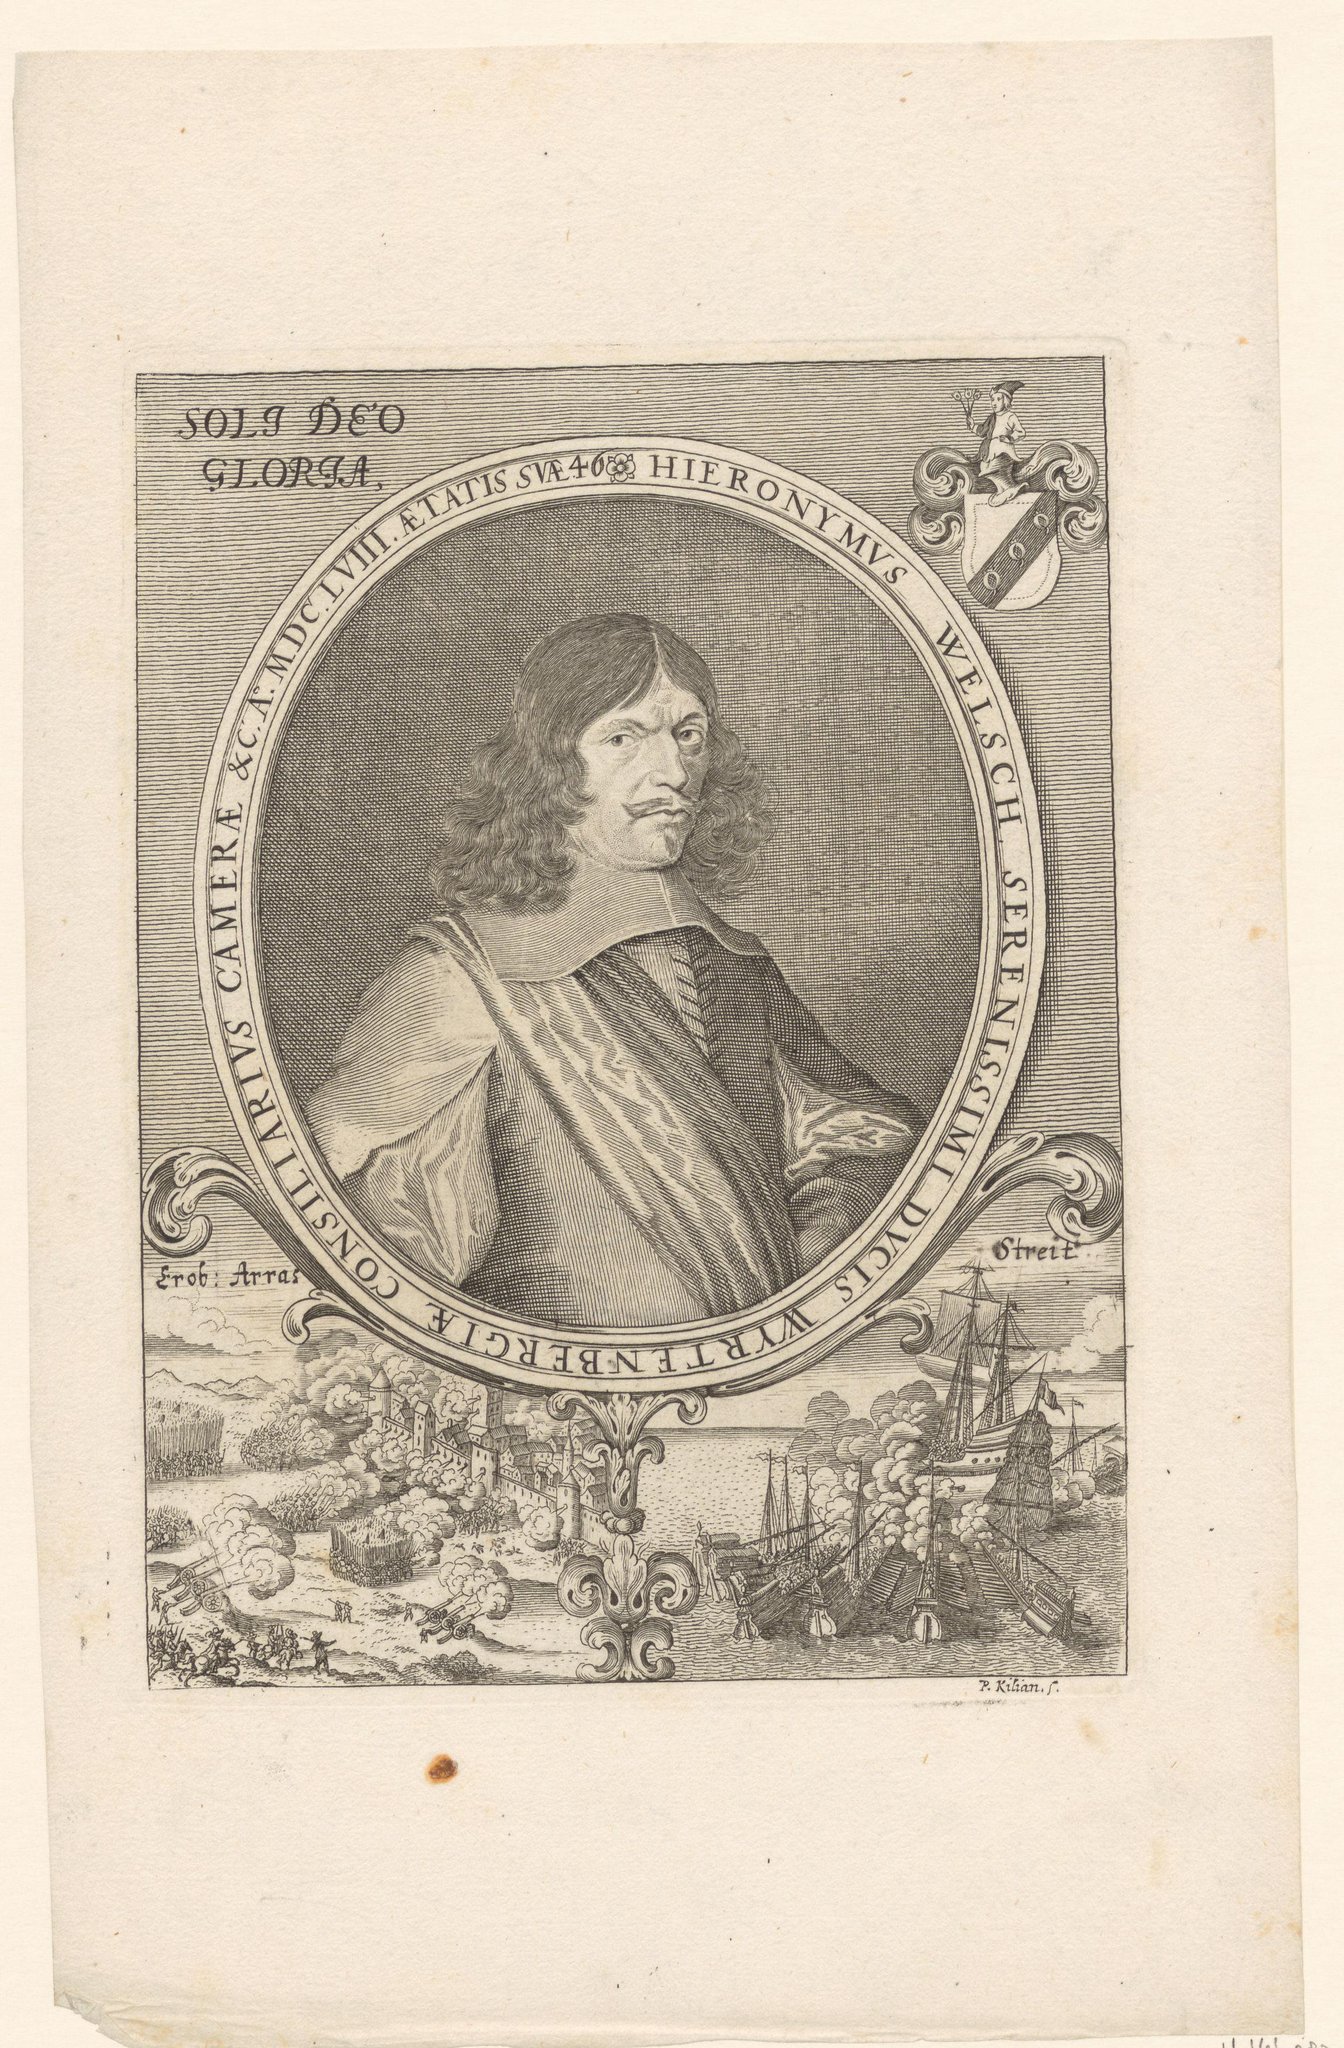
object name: print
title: Portret van Hieronymus Welsch op 46-jarige leeftijd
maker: philipp kilian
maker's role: print maker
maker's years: 1628-1693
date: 1658-1693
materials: paper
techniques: engraving, etching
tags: official, treasurer, historical persons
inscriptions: collector's mark: Lugt 2228